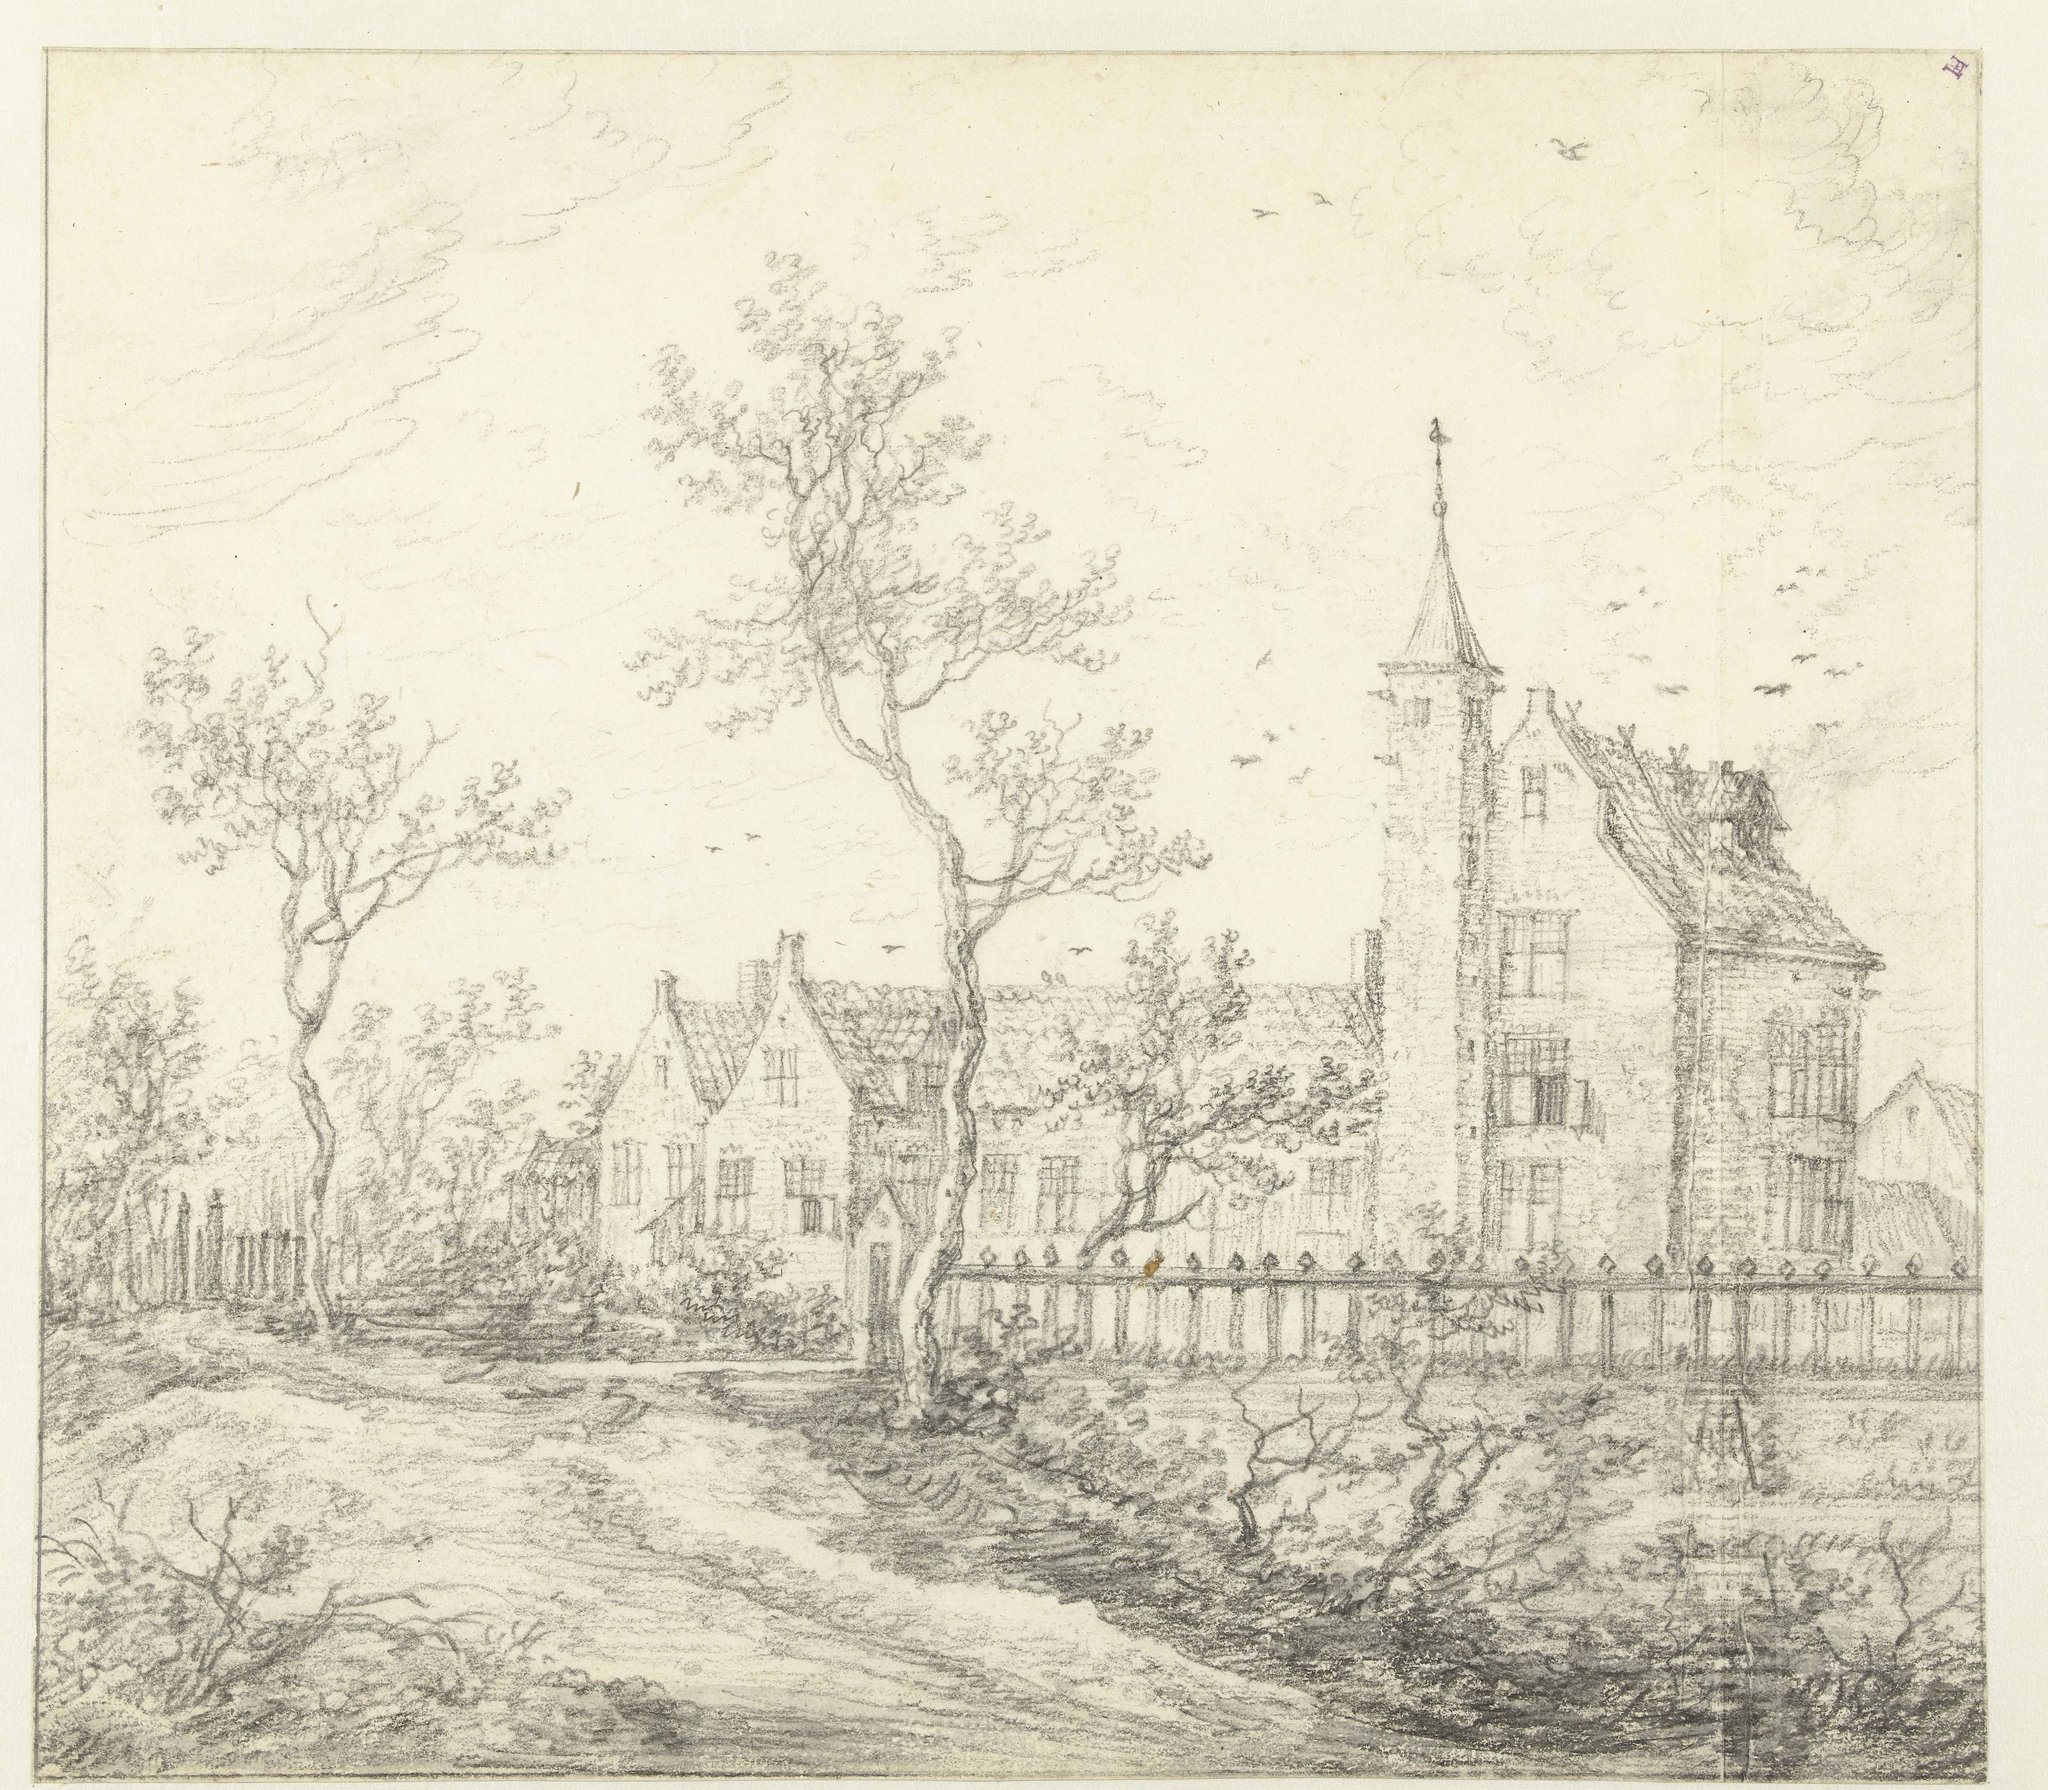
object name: drawing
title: Landhuis met toren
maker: Anonymous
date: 1637-1692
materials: chalk, paper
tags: castle